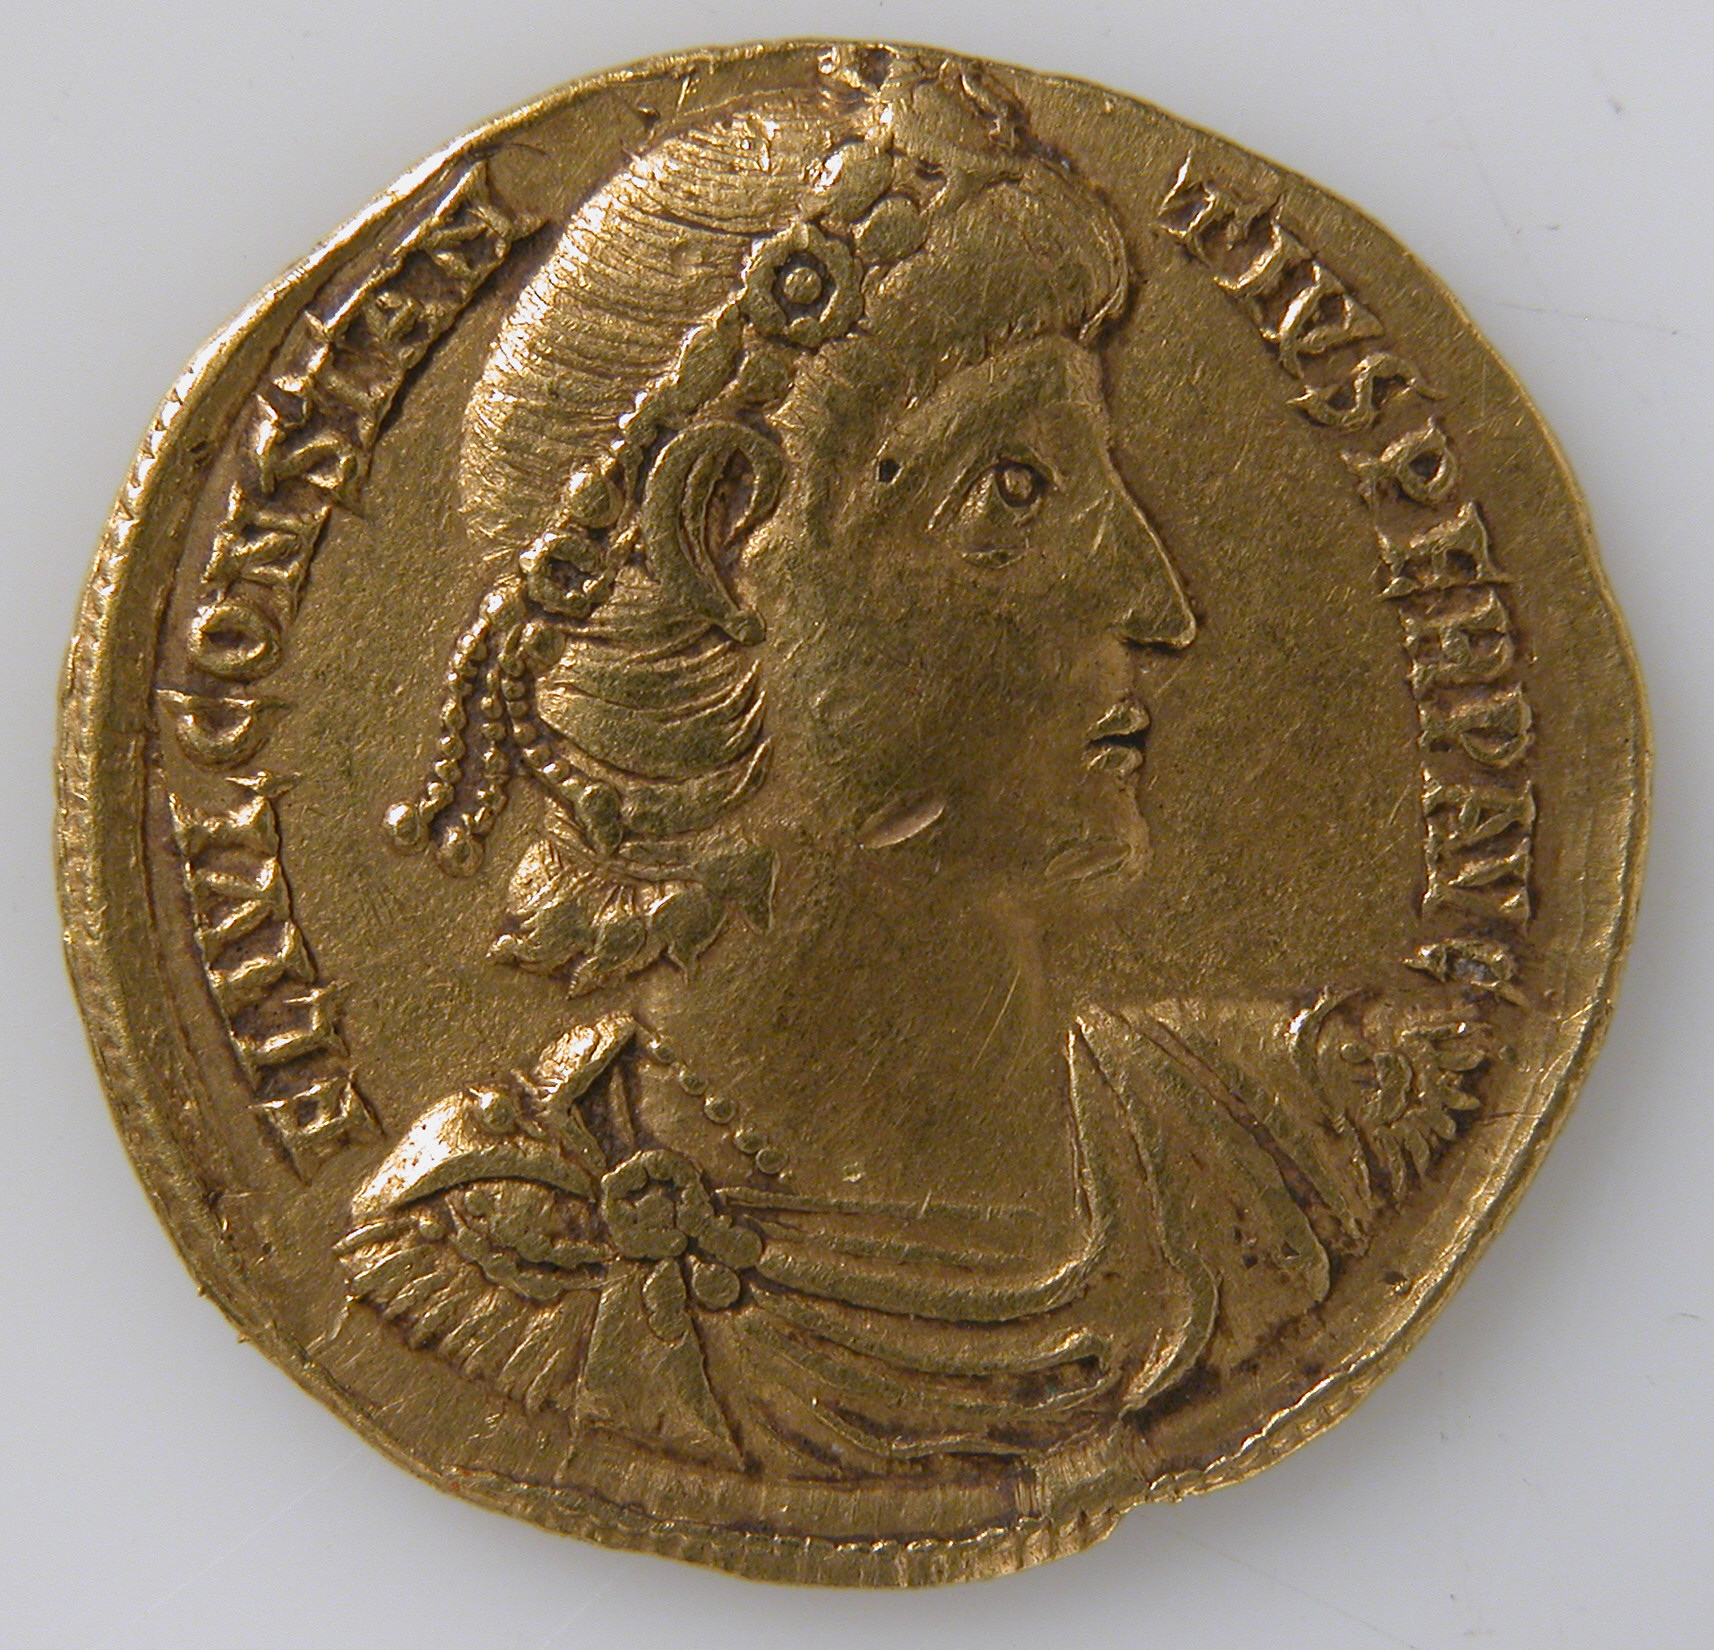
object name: solidus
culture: byzantine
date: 337-361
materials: gold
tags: profiles